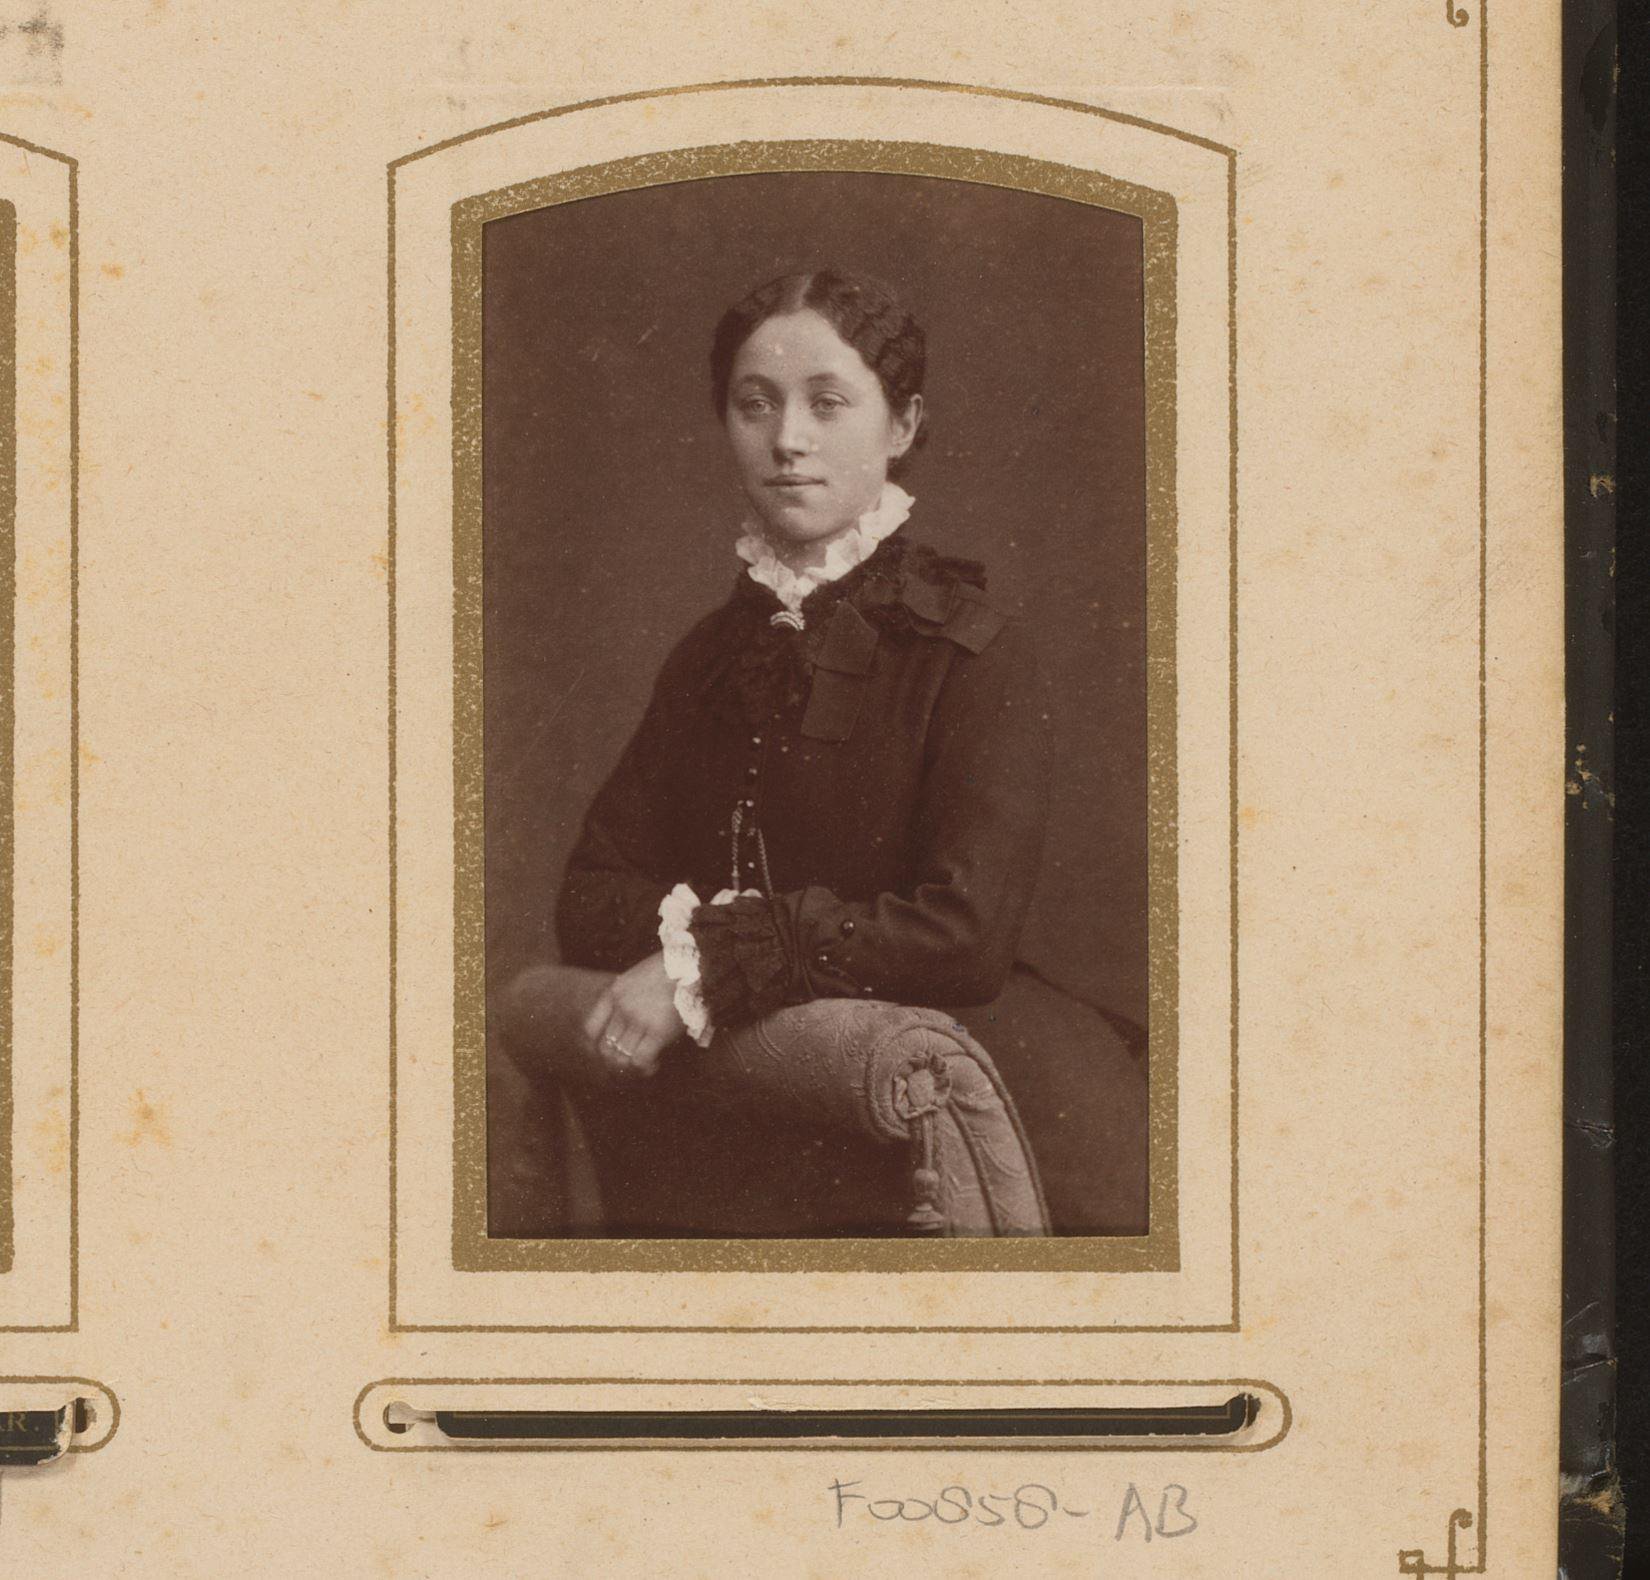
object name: album leaf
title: Portret van een jonge vrouw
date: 1884-1895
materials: cardboard, photographic support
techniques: albumen print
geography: north holland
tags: adolescent, young woman, maiden, historical persons - bb - woman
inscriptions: inscription: ‘Alkmaar, Verdronken Oord; Nieuwediep, Kanaalweg tegenover Tivoli’